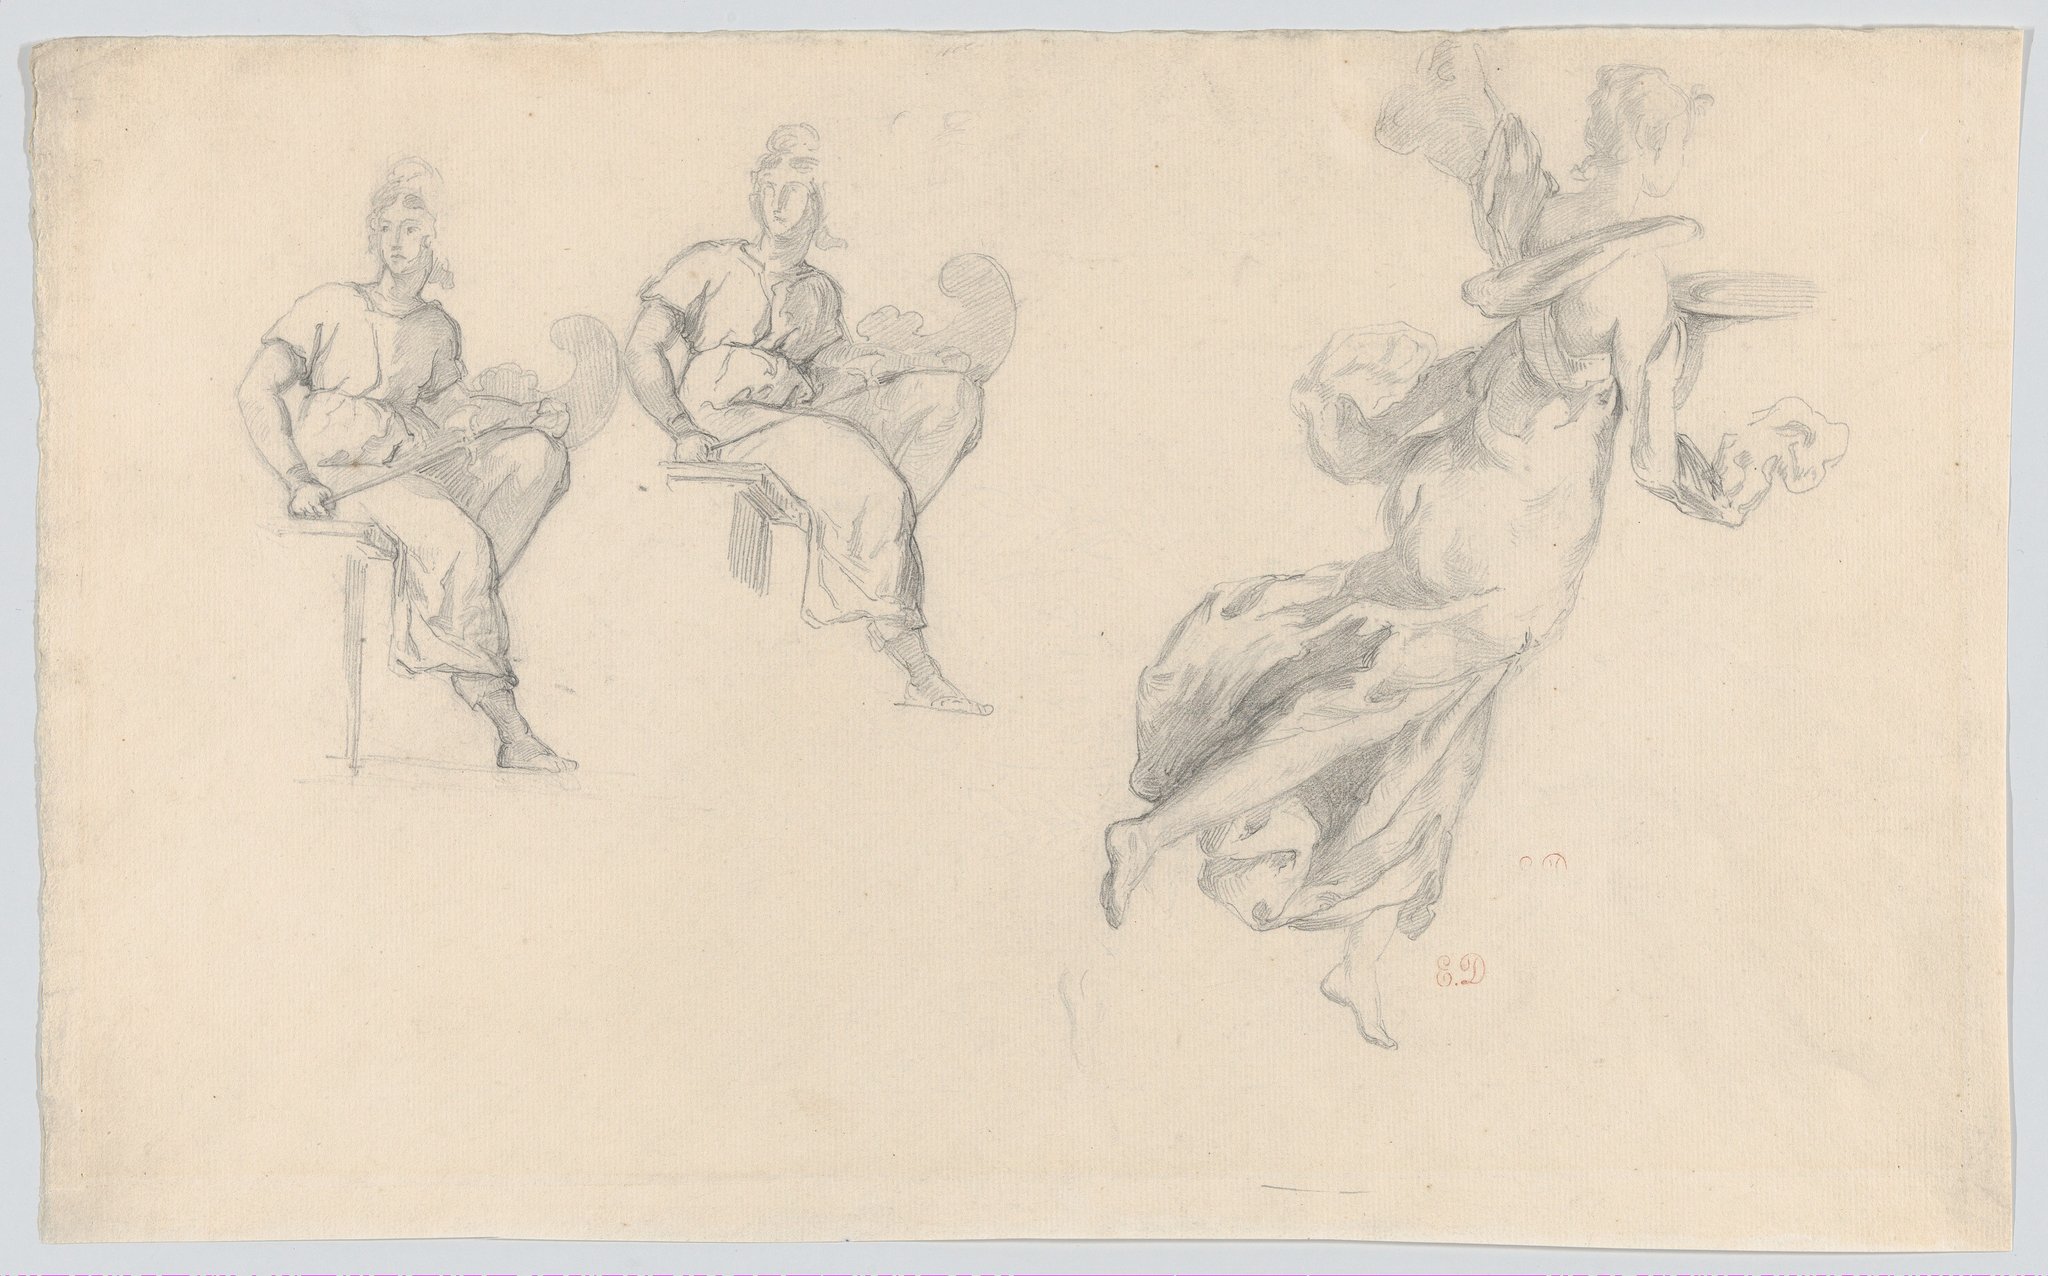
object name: drawing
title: Three Female Figures from the Antique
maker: eugène delacroix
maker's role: artist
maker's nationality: french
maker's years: 1798-1863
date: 1820-1863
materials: graphite